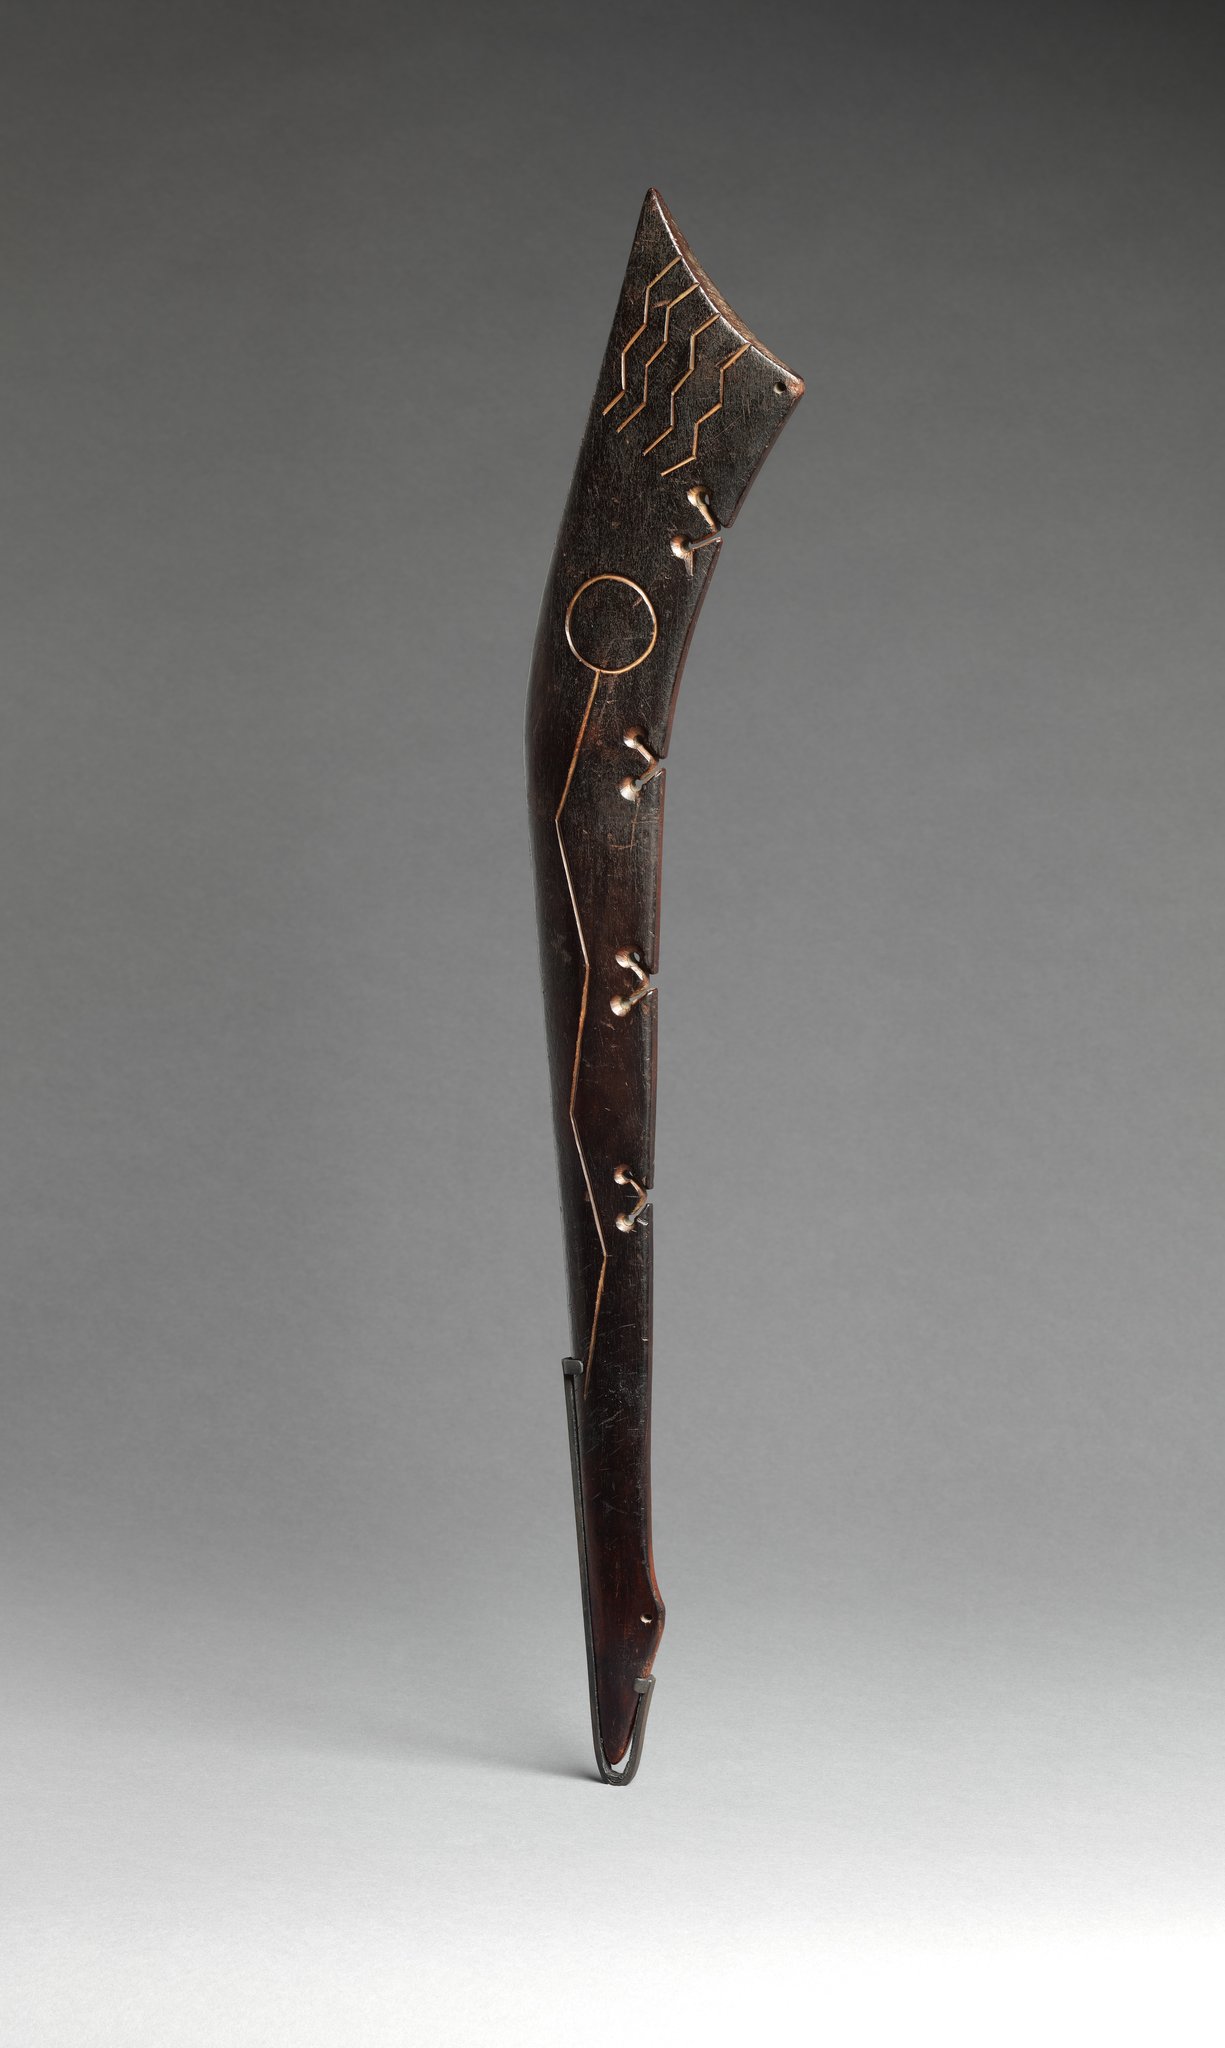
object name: war club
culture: pawnee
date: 1800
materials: pigment, wood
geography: united states